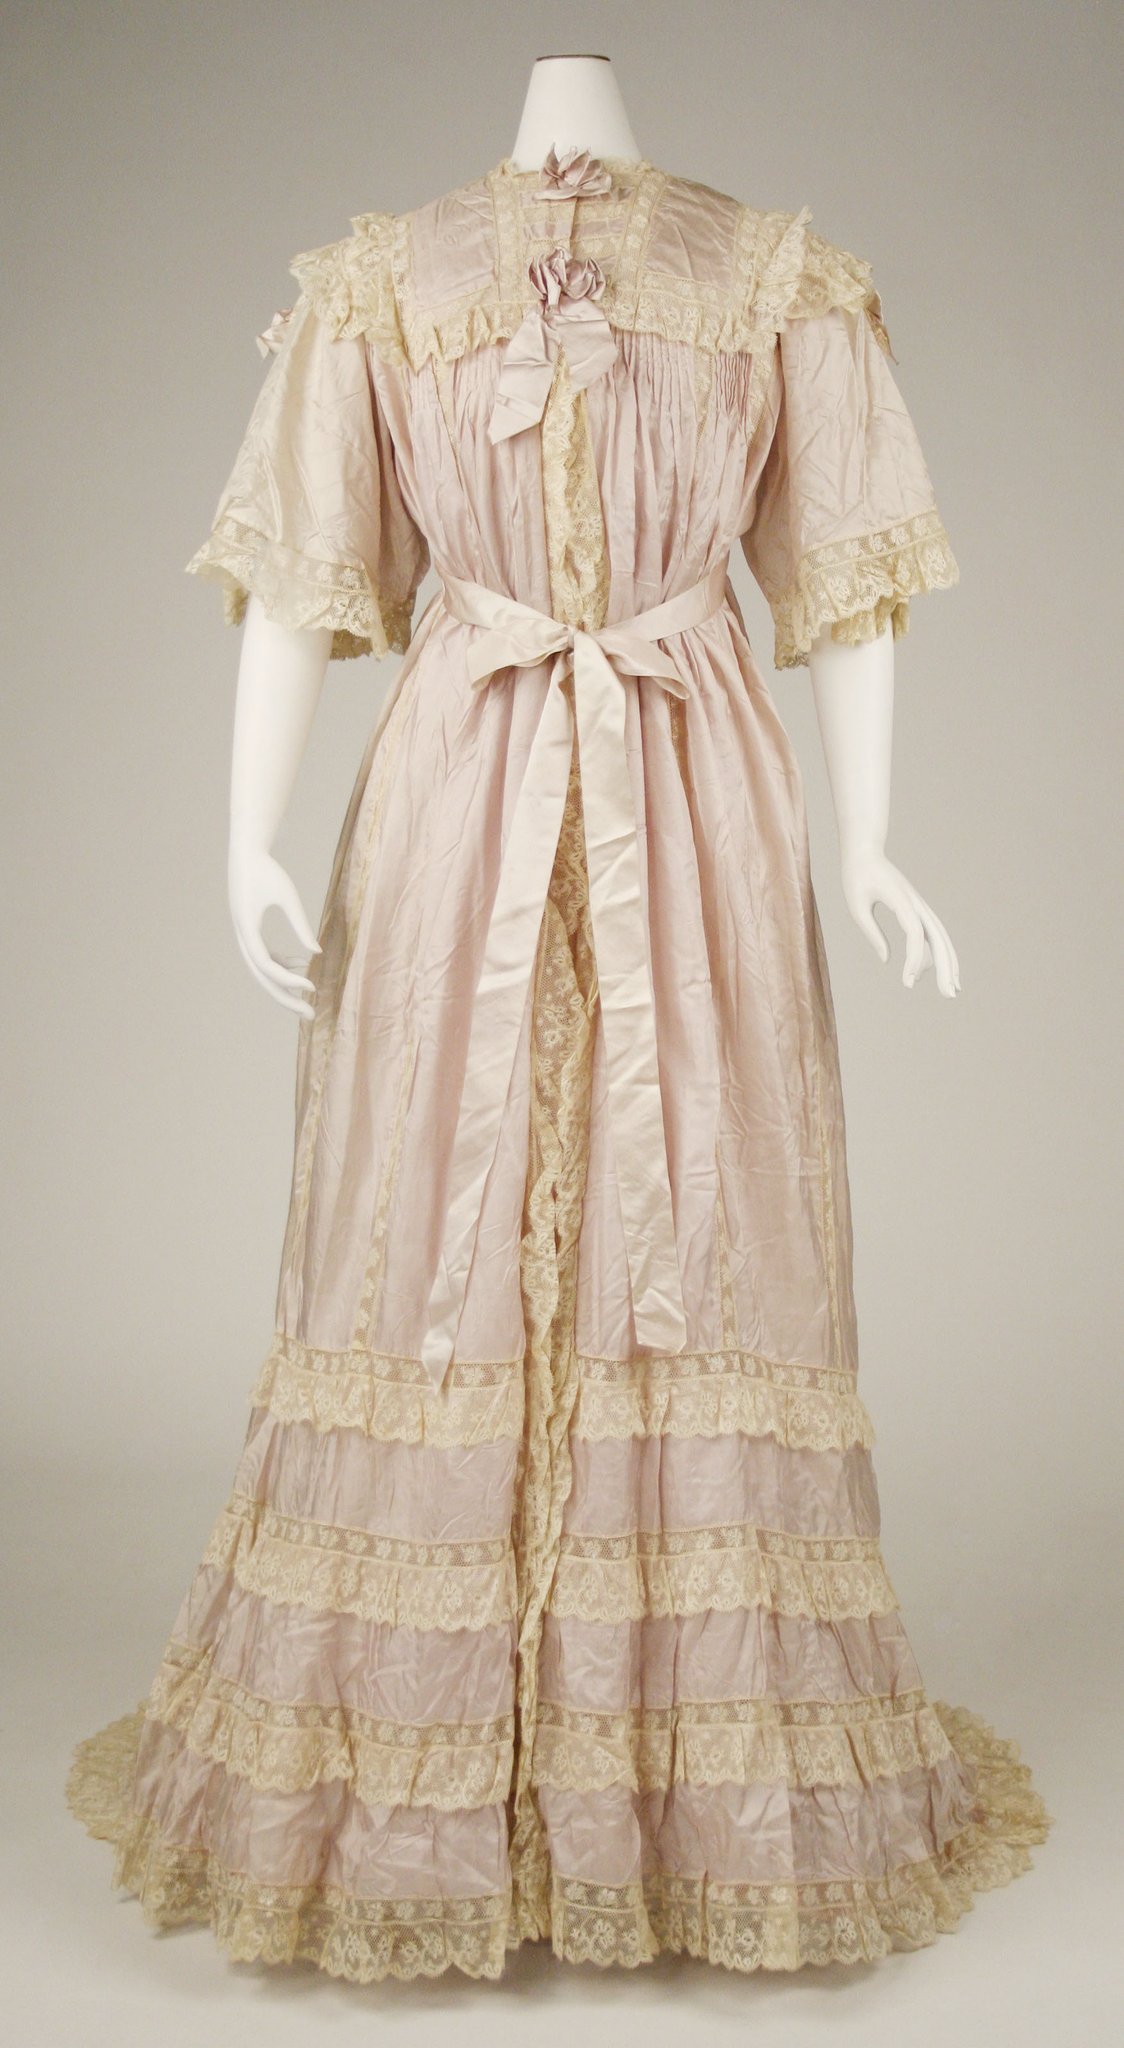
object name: negligée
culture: american or european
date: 1900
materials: cotton, silk